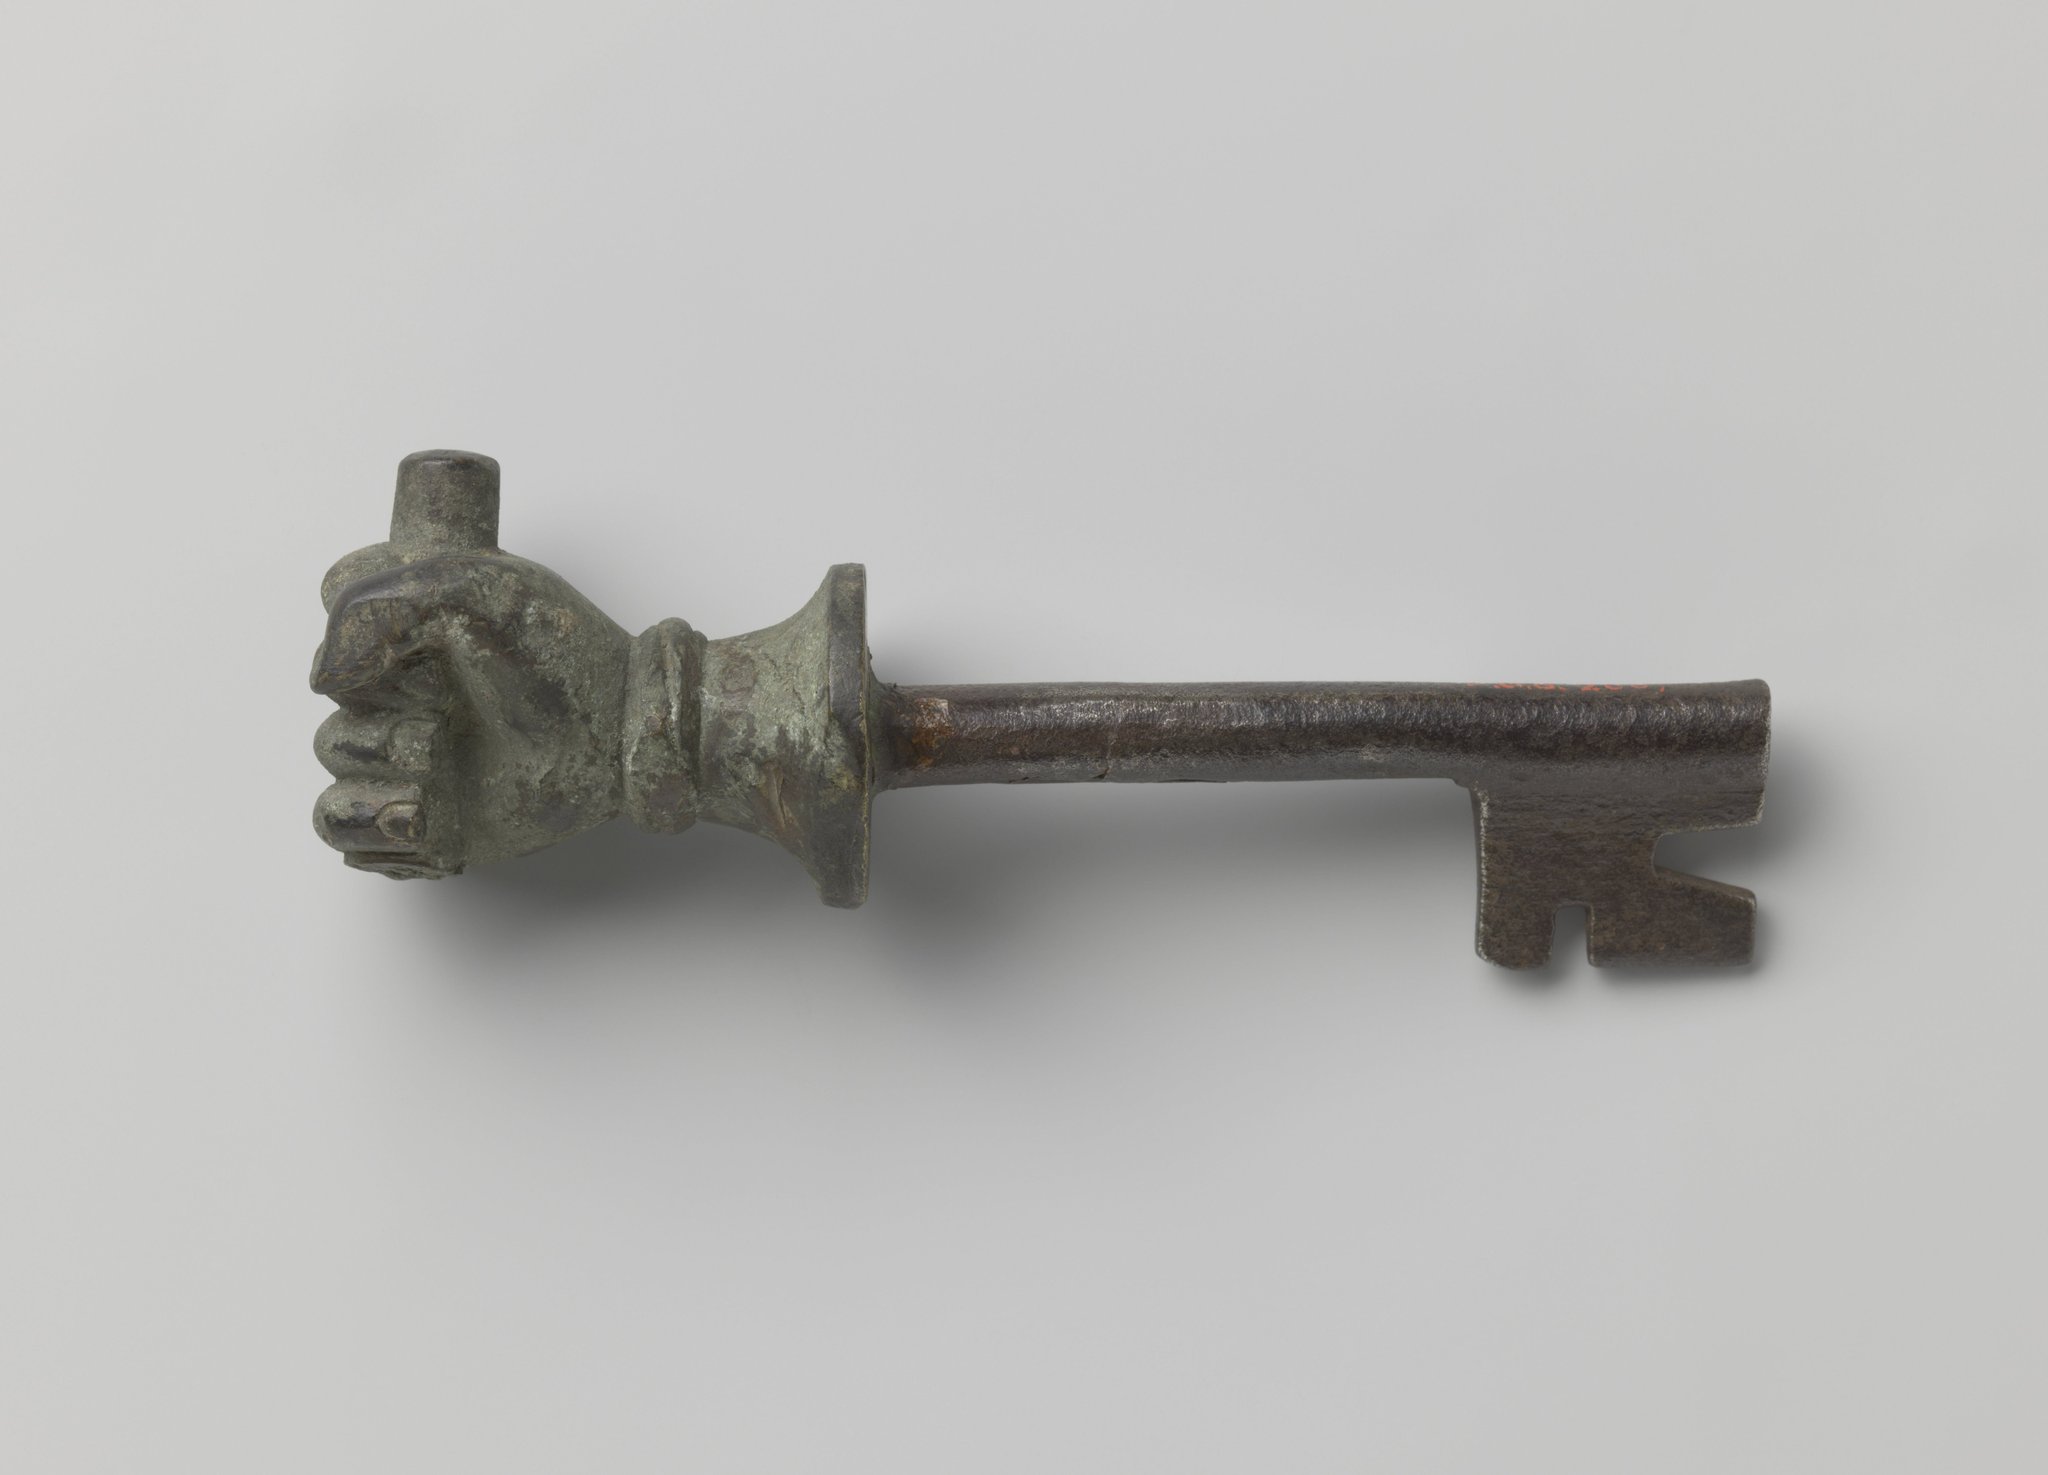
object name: pipe key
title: Pijpsleutel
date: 1400-1950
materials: bronze, iron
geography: rome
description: Pijpsleutel met greep in de vorm van een vuist, een afgebroken staf vasthoudend. Greep van brons, baard en schacht van ijzer.